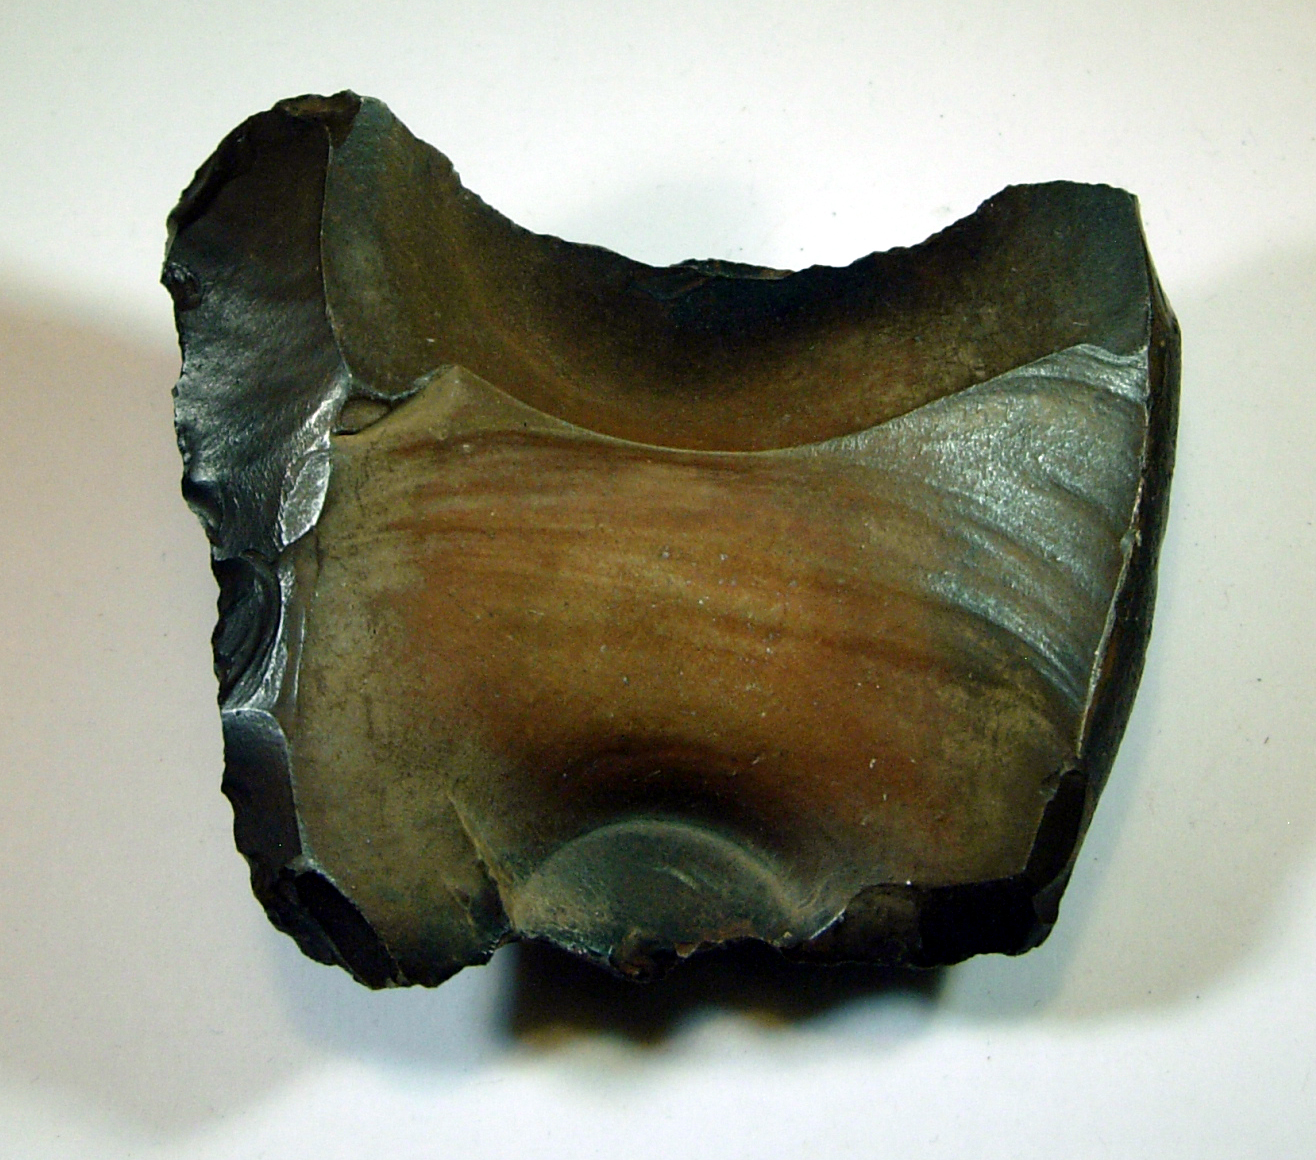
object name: tool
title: Tool (?)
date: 5000-3100 BCE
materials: stone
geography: egypt